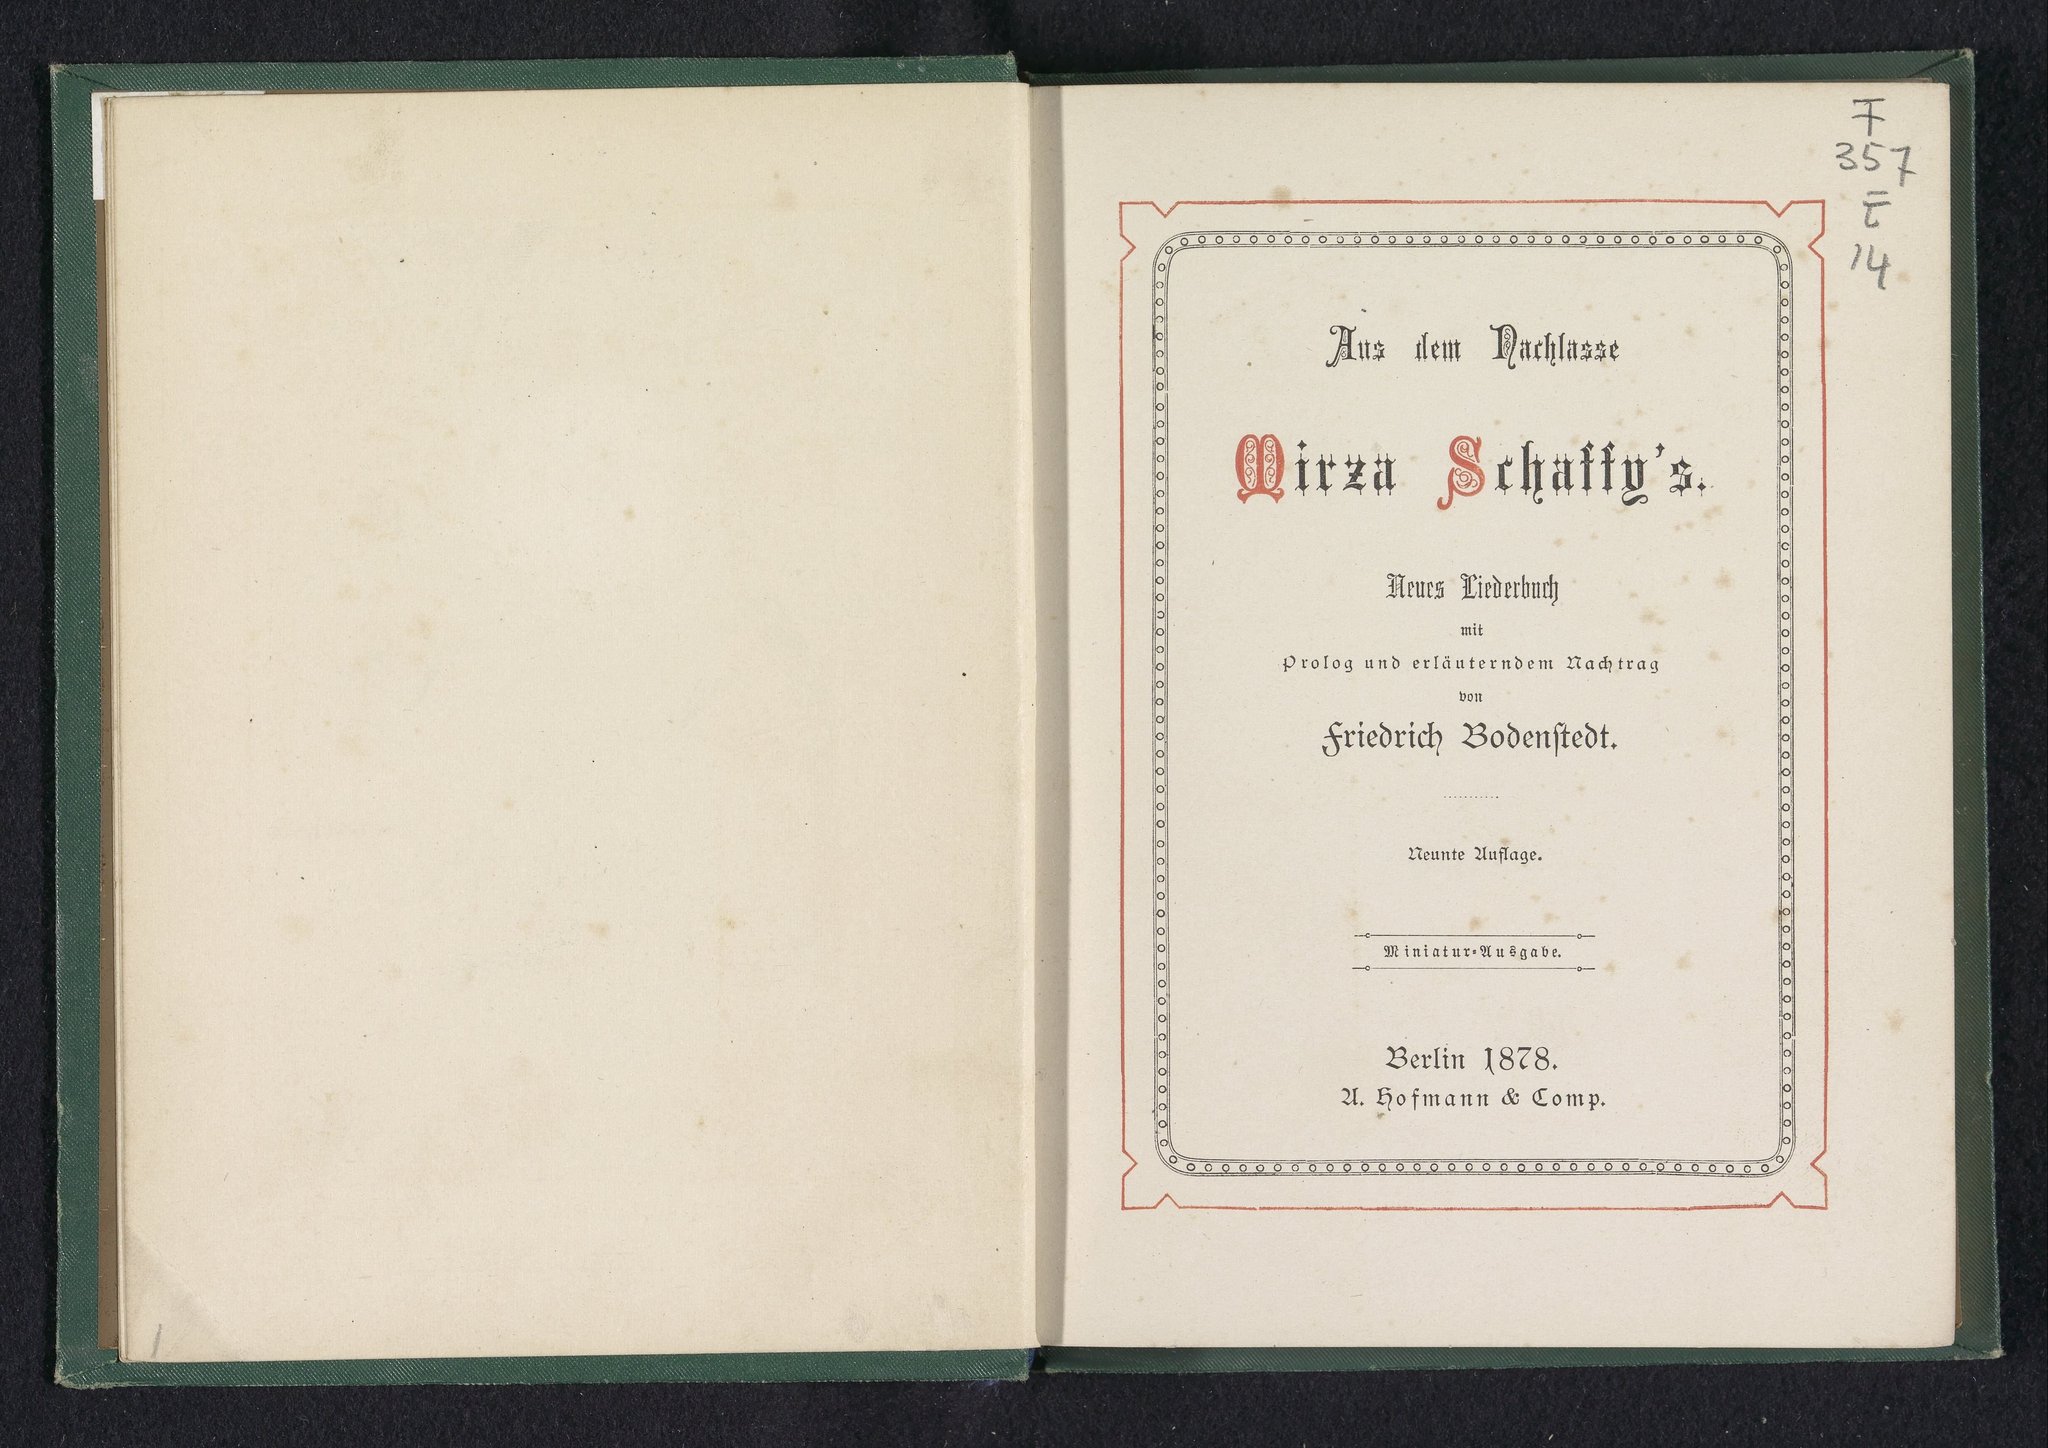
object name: book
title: Aus dem Nachlasse Mirza Schaffy's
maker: friedrich von bodenstedt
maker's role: cultuurhistoricus, schrijver, vertaler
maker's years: 1819-1892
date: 1878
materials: cardboard, linen, paper, photographic support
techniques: albumen print, printing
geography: berlin